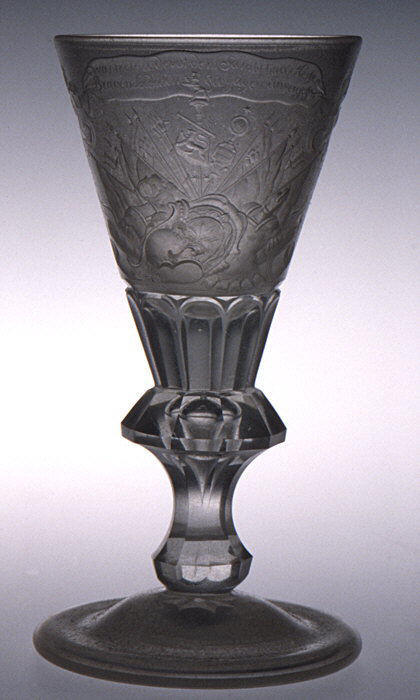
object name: goblet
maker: franz gundelach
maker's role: engraver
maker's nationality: german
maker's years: 1650-1750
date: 1701-1800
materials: glass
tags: putti,trophies